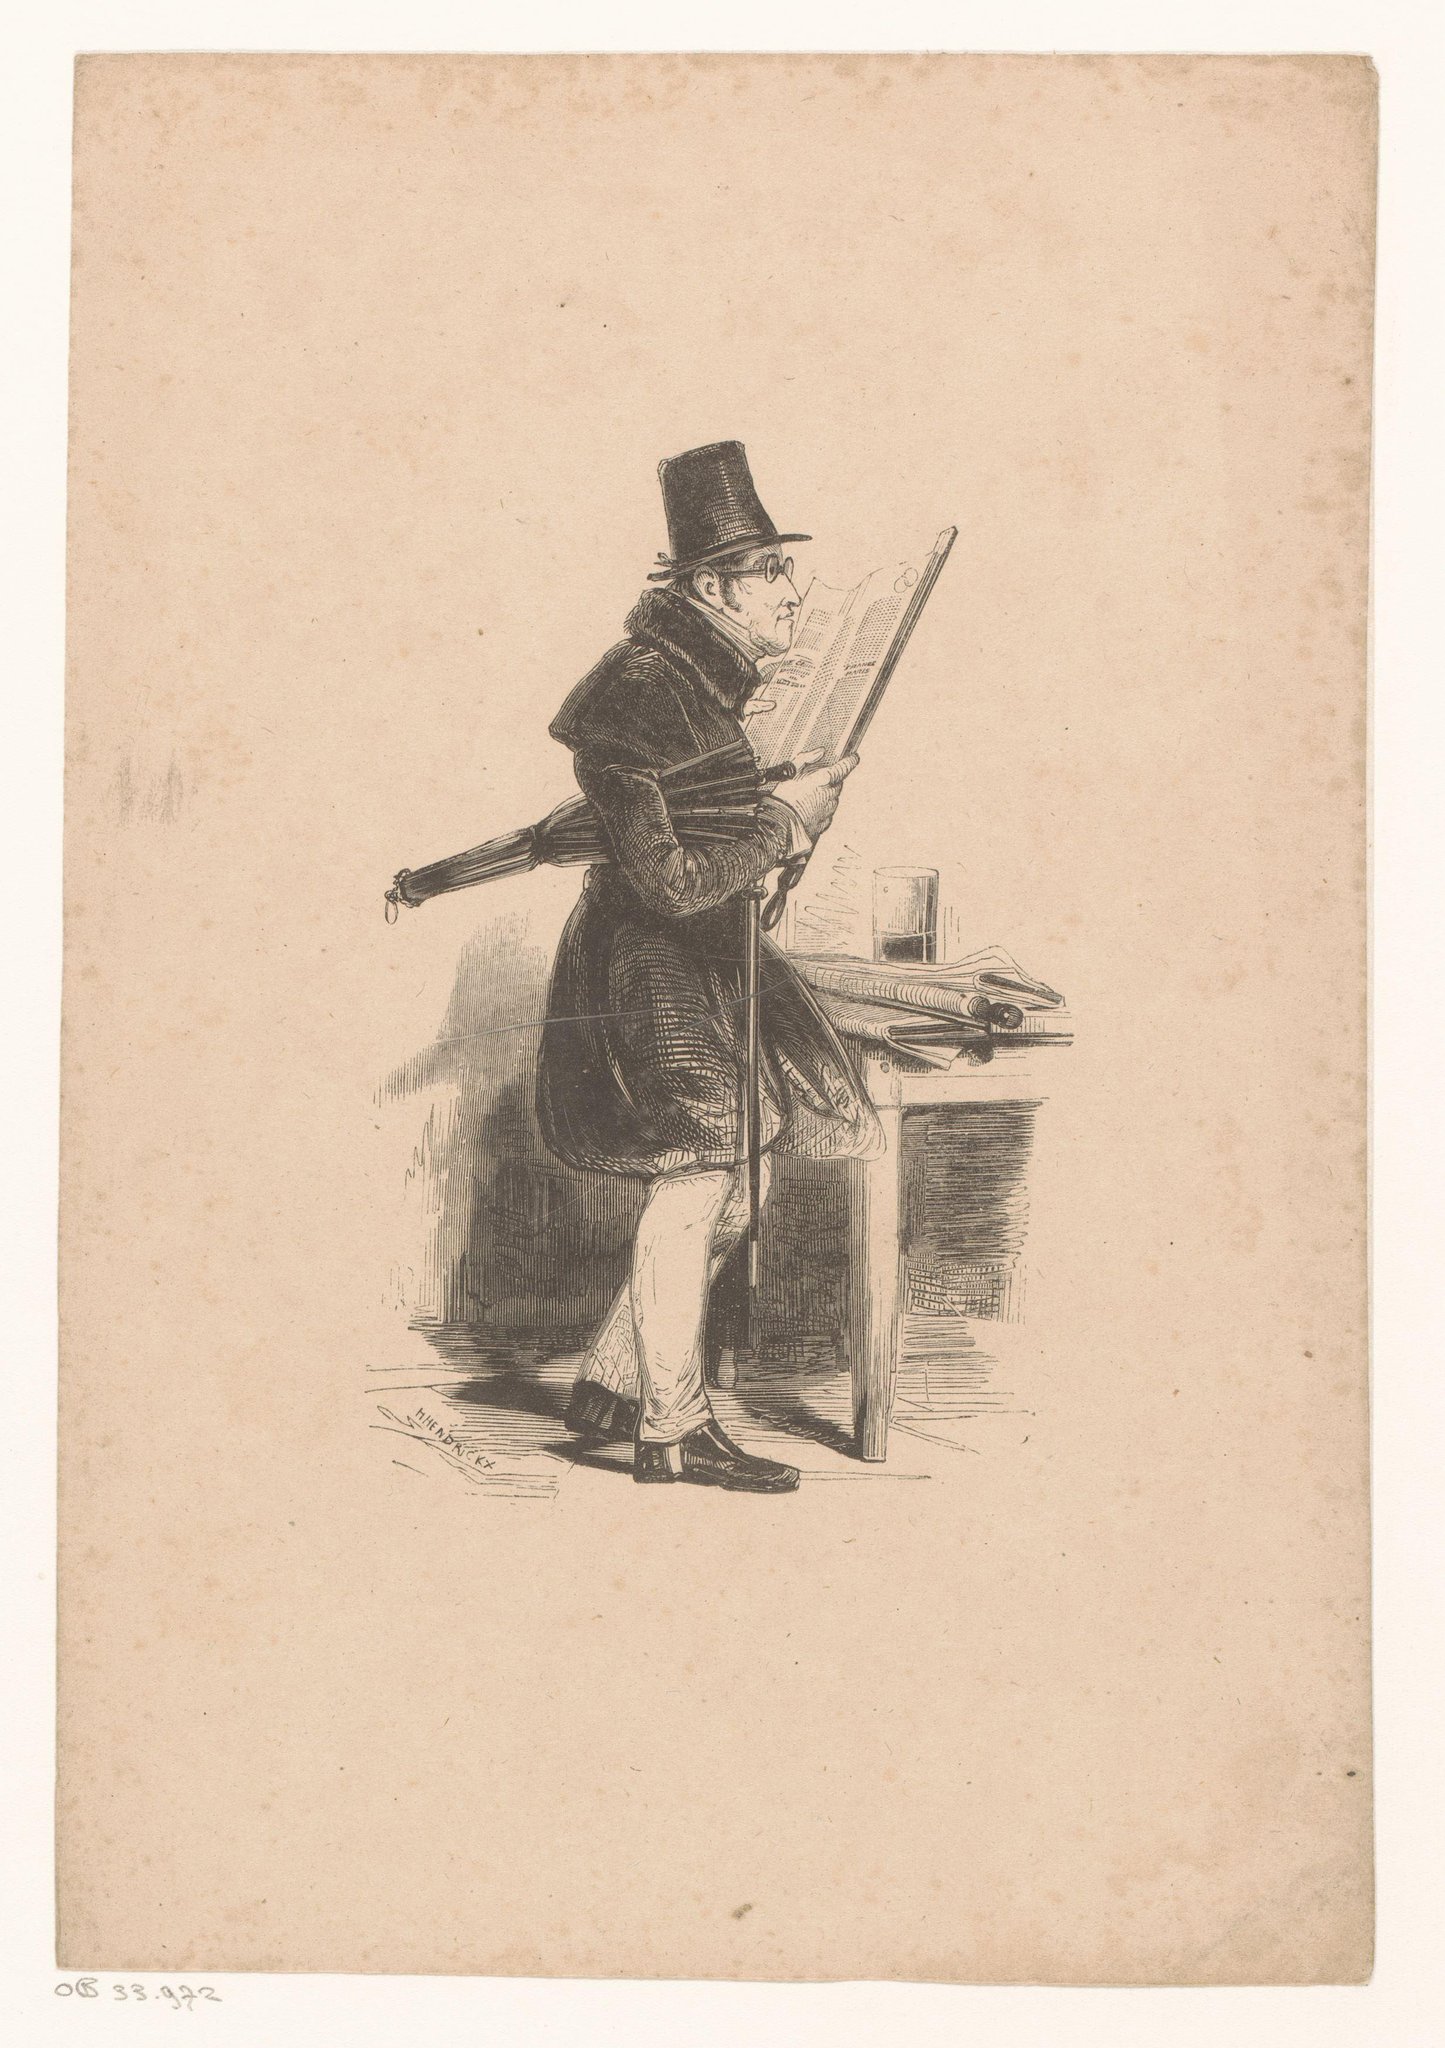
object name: print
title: Man met hoed en paraplu leest een krant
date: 1826-1870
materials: paper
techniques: engraving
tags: adult man, umbrella, newspaper, news-sheet, head-gear: top hat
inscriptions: collector's mark: Lugt 2228